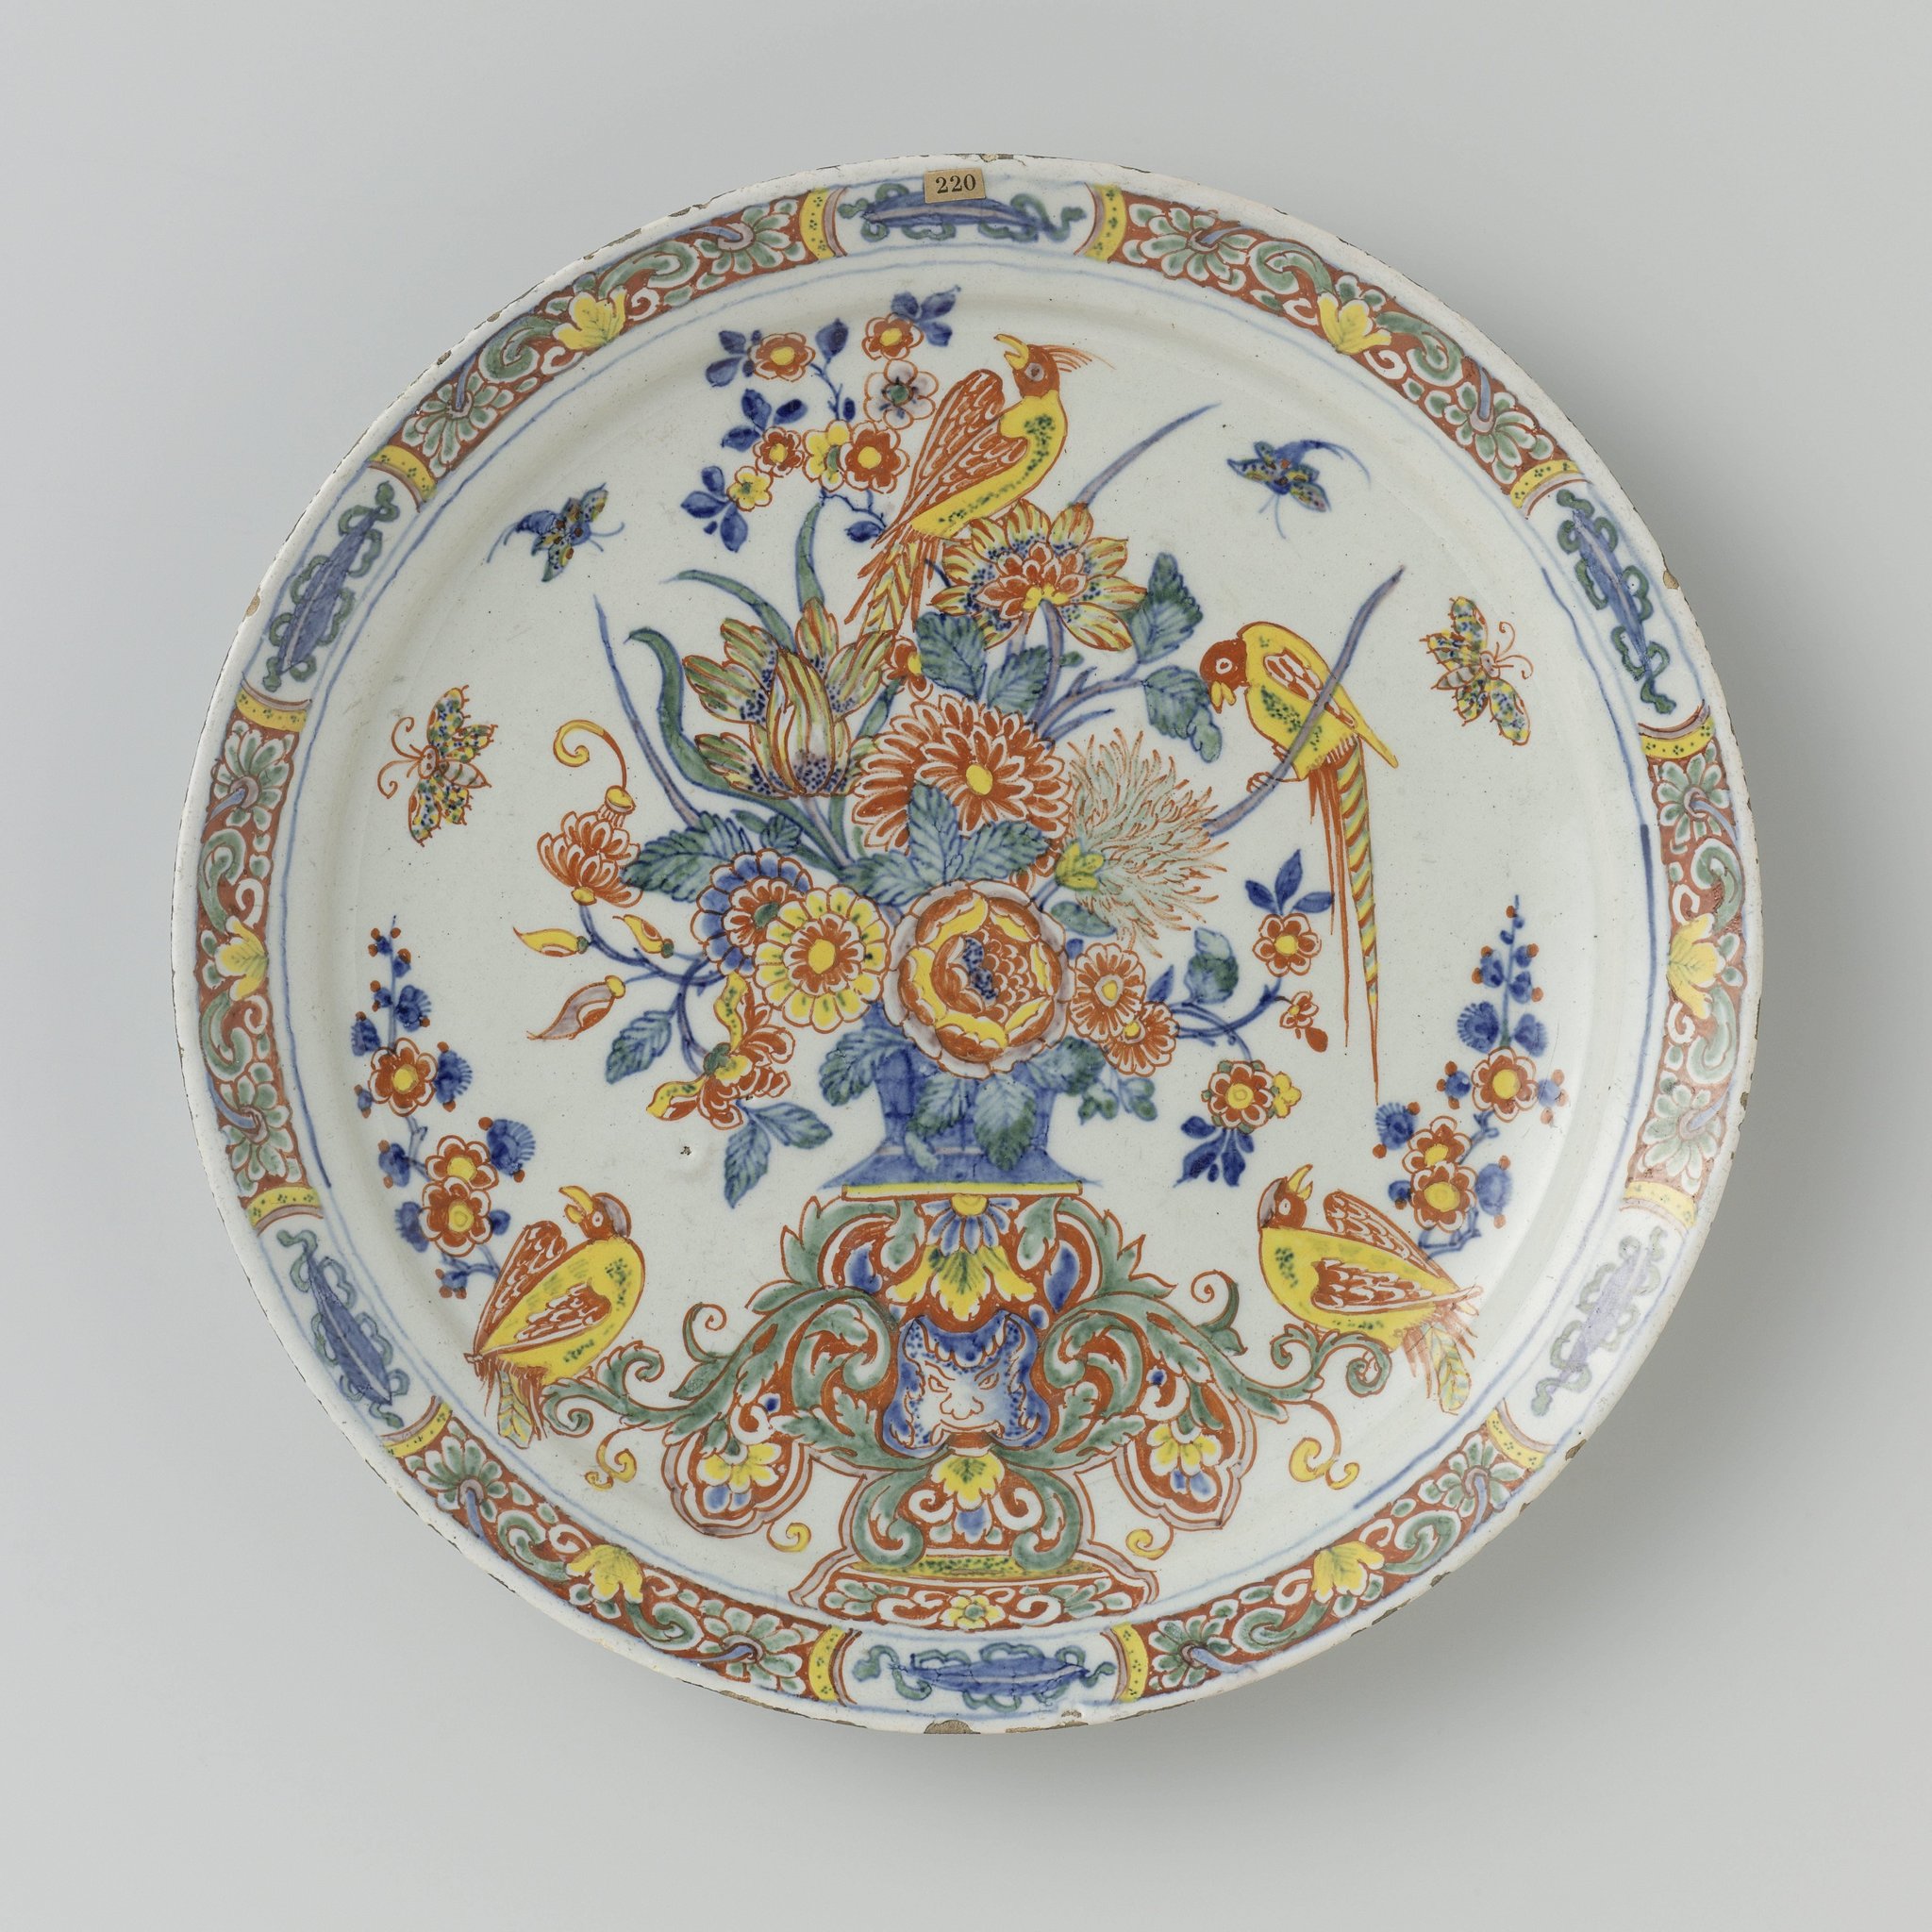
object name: plate dish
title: Bord, beschilderd met een korf met bloemen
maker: Anonymous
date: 1710-1730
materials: faience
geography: delft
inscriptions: seal: ‘220’, collector's mark: ‘collection J.F. Loudon’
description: Bord van faïence. Veelkleurig beschilderd met een korf met bloemen. Rand met ranken en Chinese motieven.